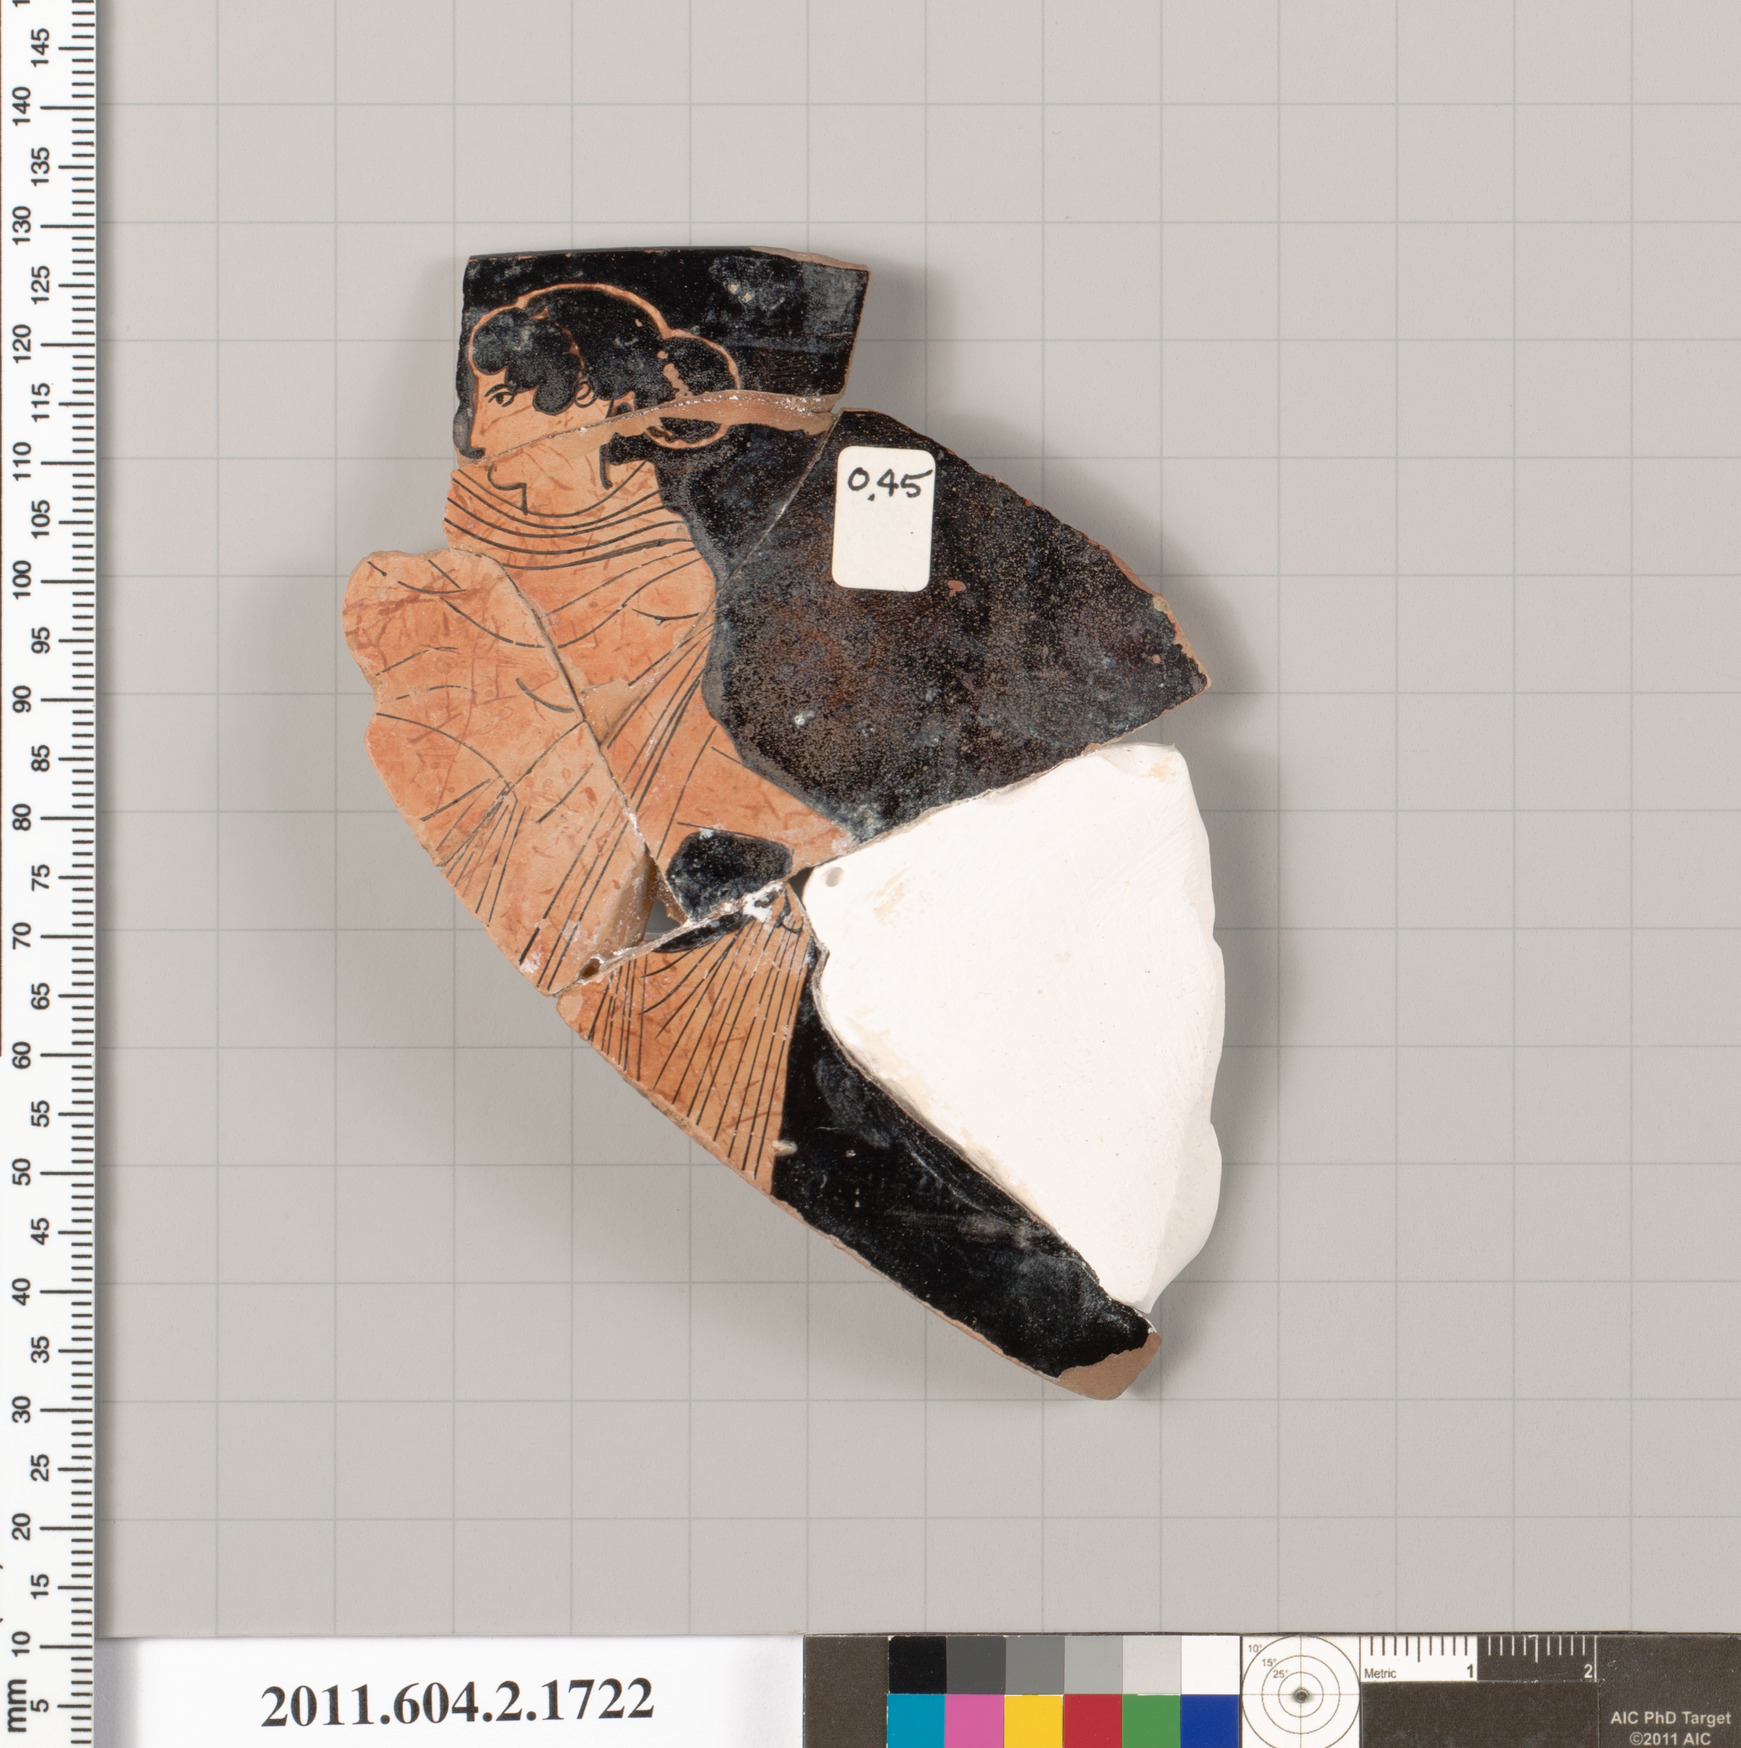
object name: skyphos fragment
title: Terracotta fragment of a skyphos (deep drinking cup)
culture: greek, attic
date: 460-450 BCE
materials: terracotta